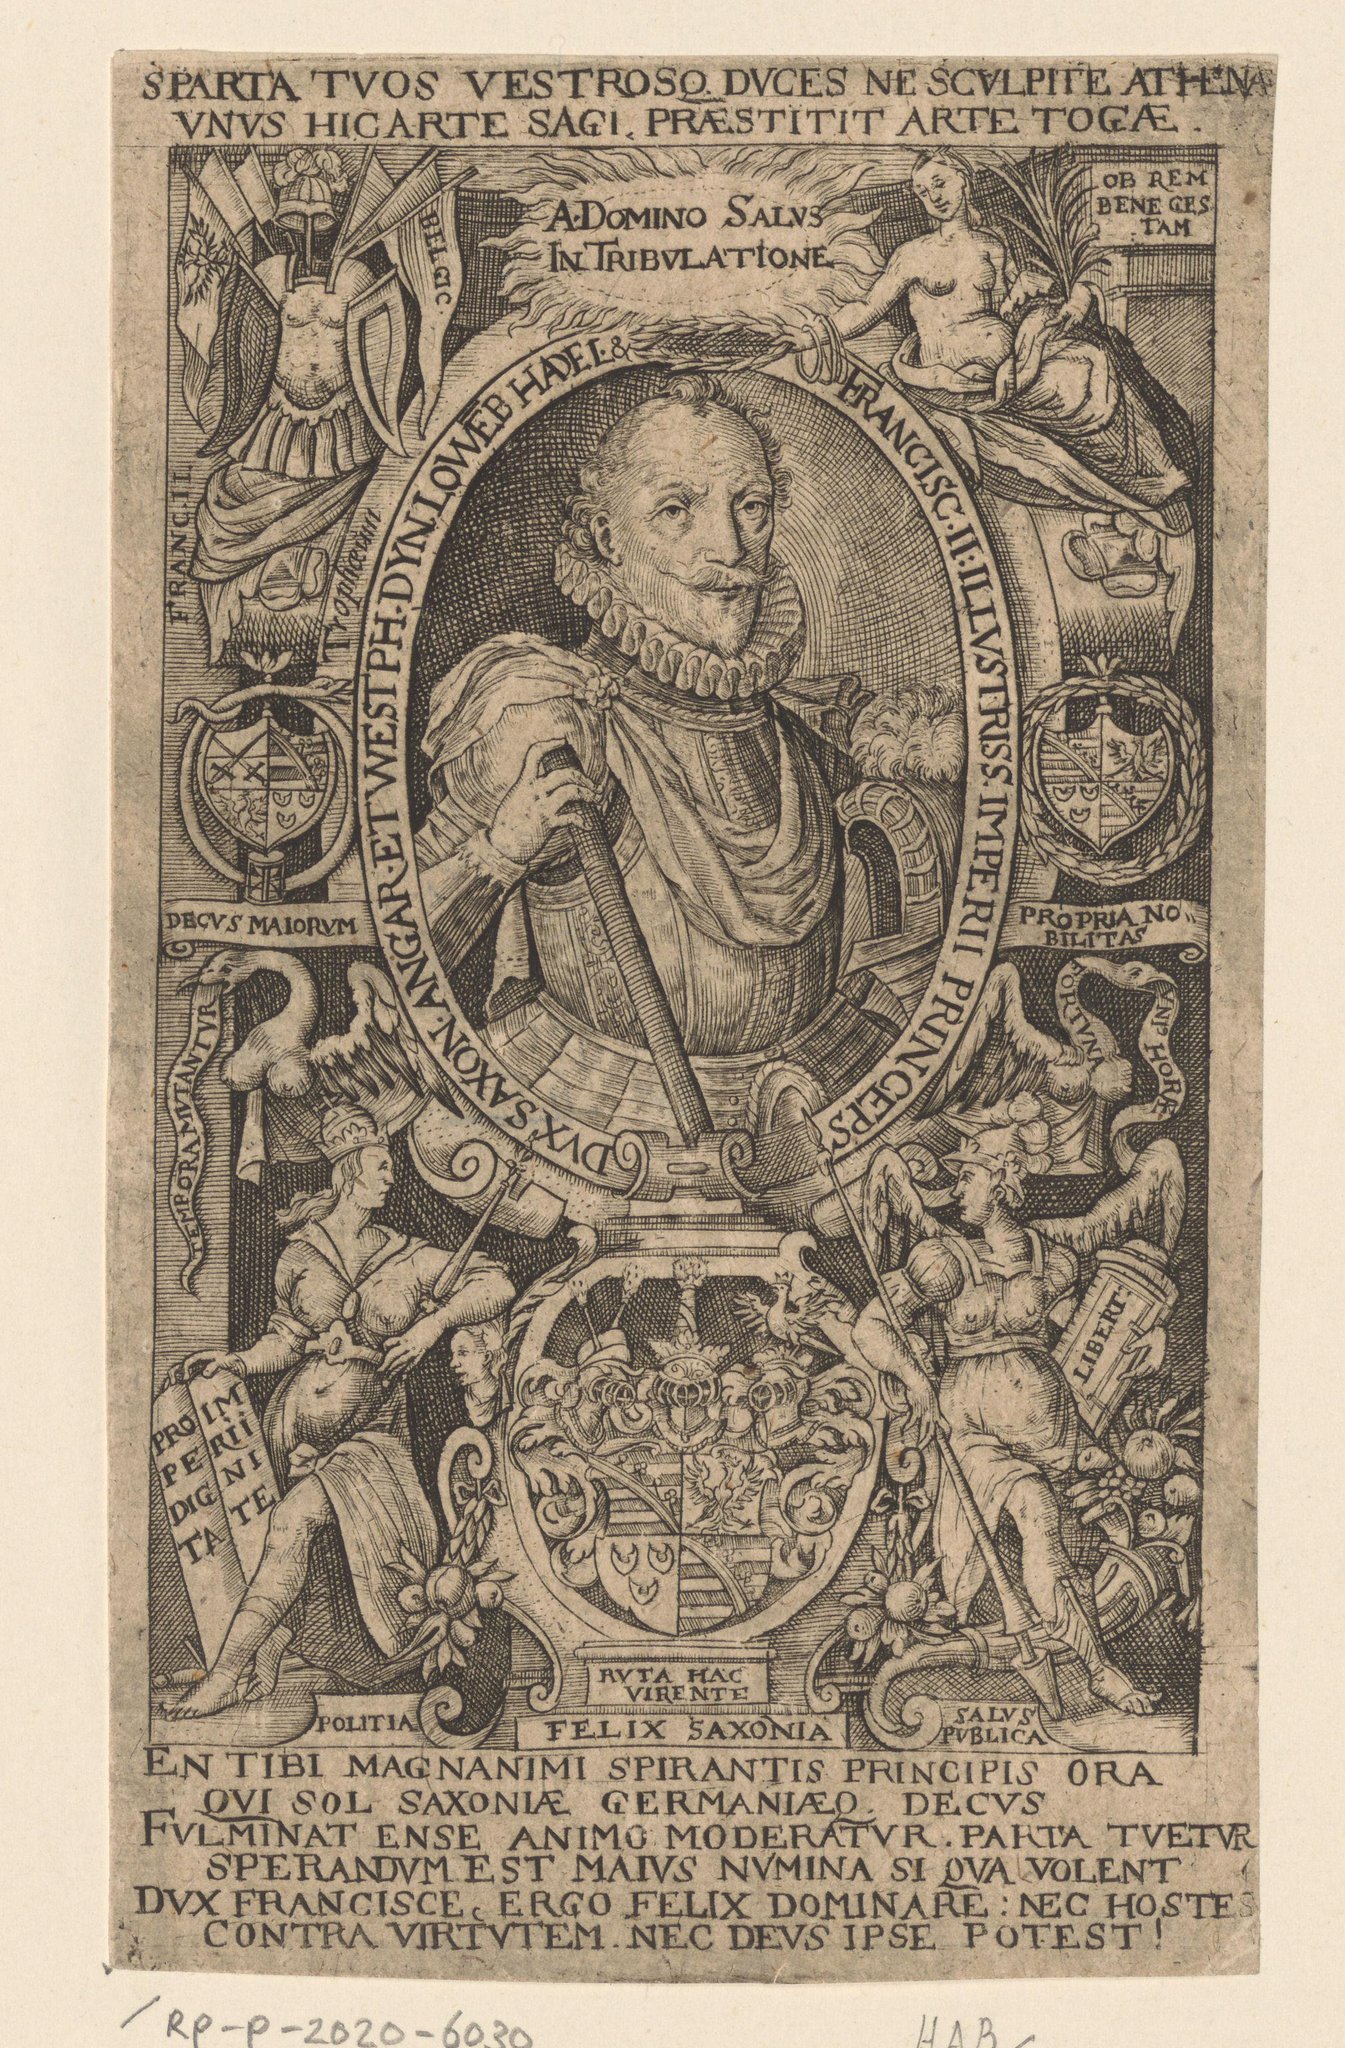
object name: print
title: Portret van Frans II van Saksen-Lauenburg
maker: Anonymous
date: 1581-1619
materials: chalk, paper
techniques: engraving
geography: germany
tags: armour, historical persons, crowning with laurel, armorial bearing, heraldry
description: Portret in medaillon met rondom verschillende figuren, tekst en wapens. Met zesregelig onderschrift in het Latijn.